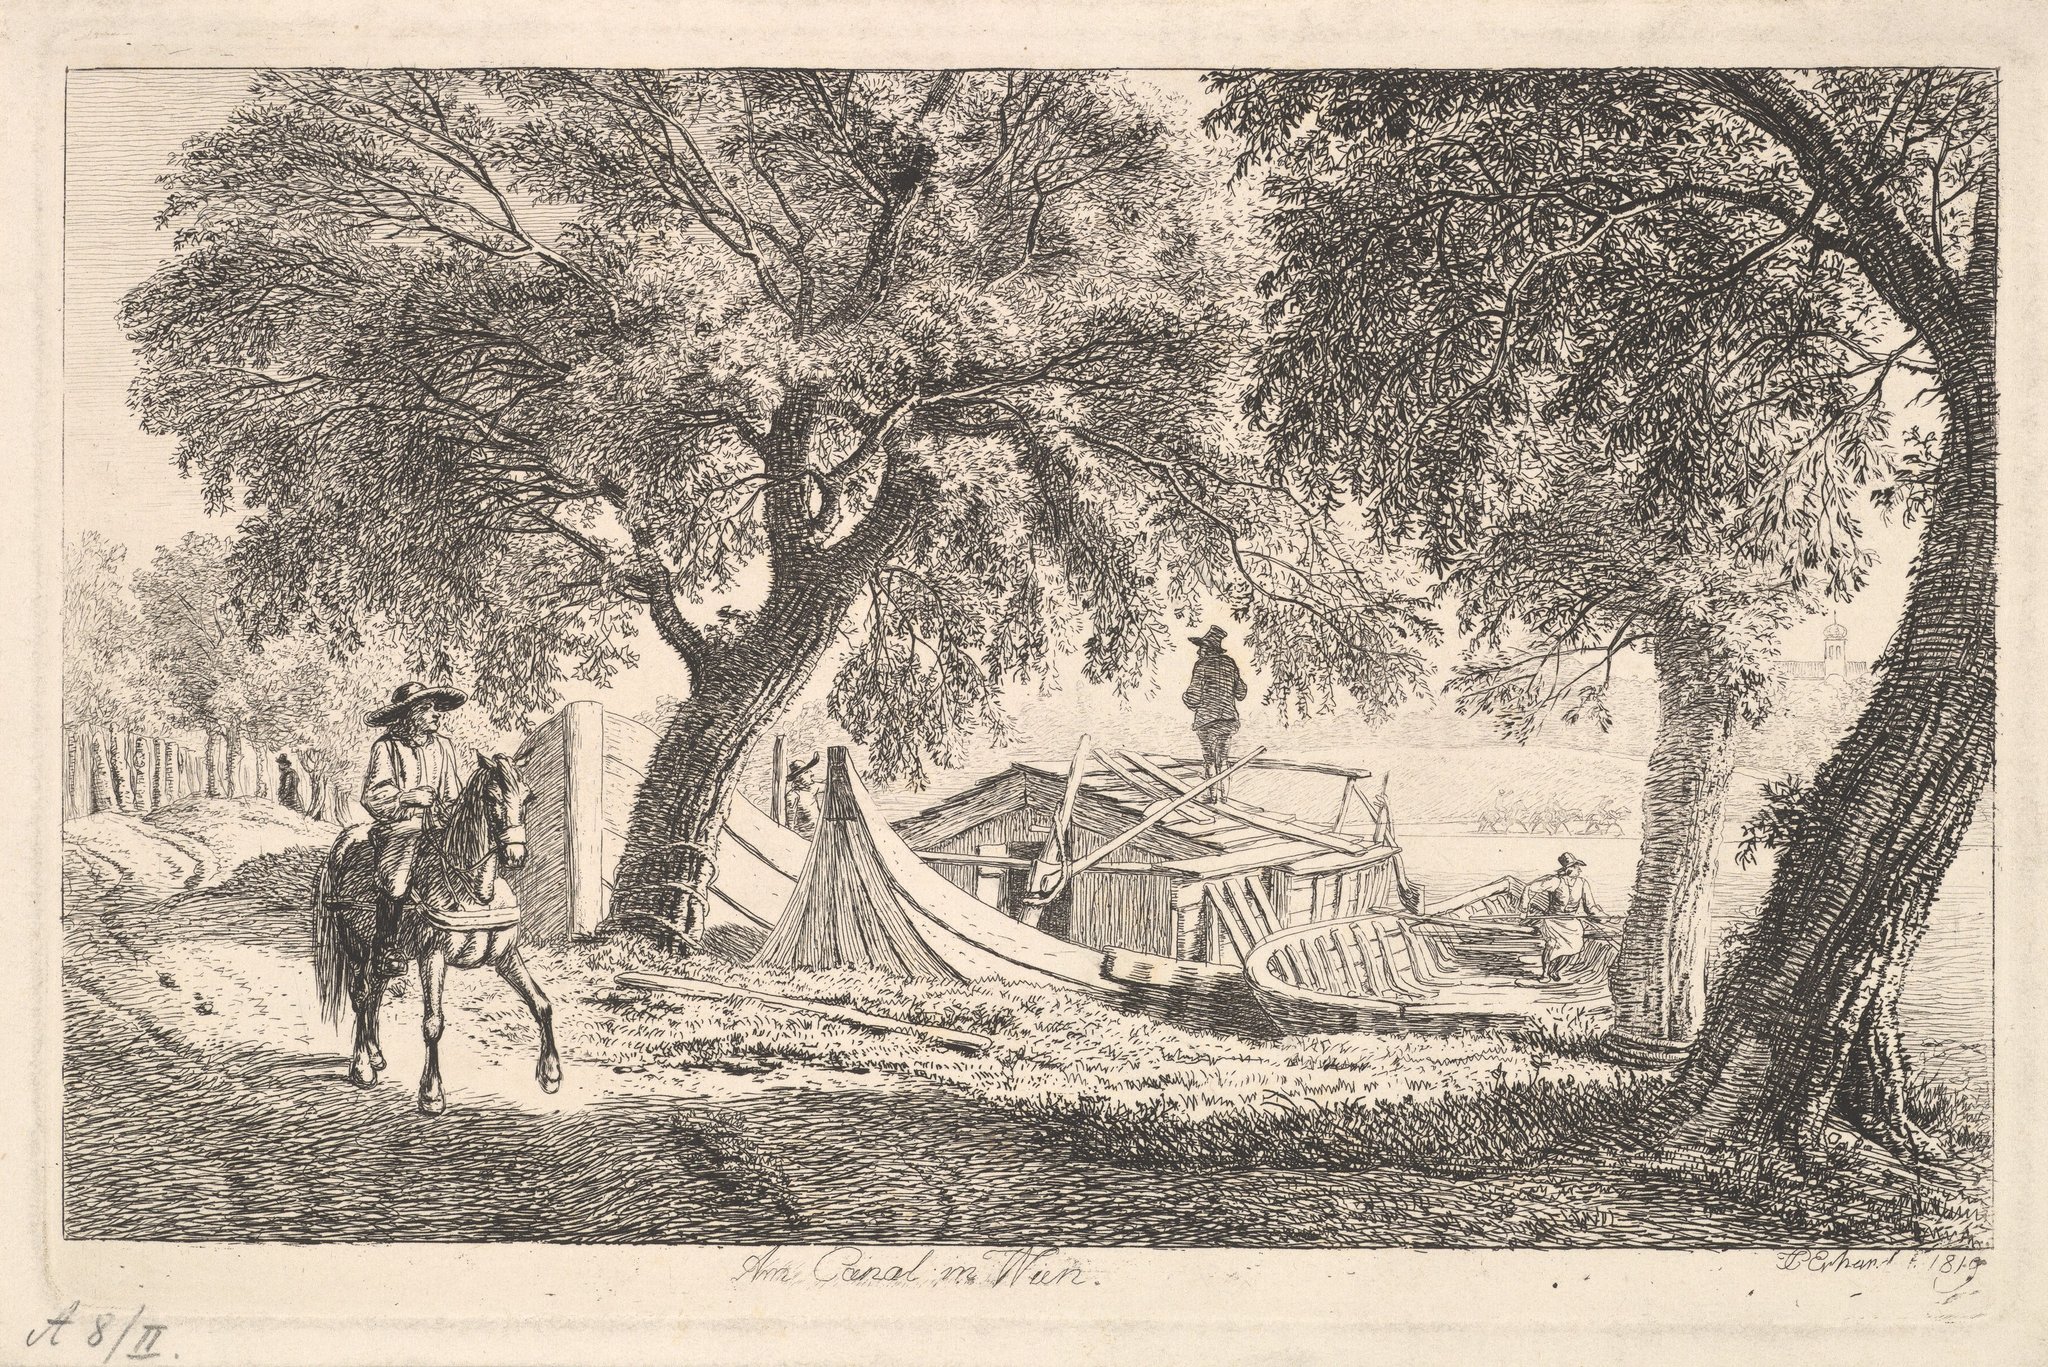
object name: print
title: On the Canal in Vienna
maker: johann christoph erhard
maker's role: artist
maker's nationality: german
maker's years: 1795-1822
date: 1819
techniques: etching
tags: men,horses,trees